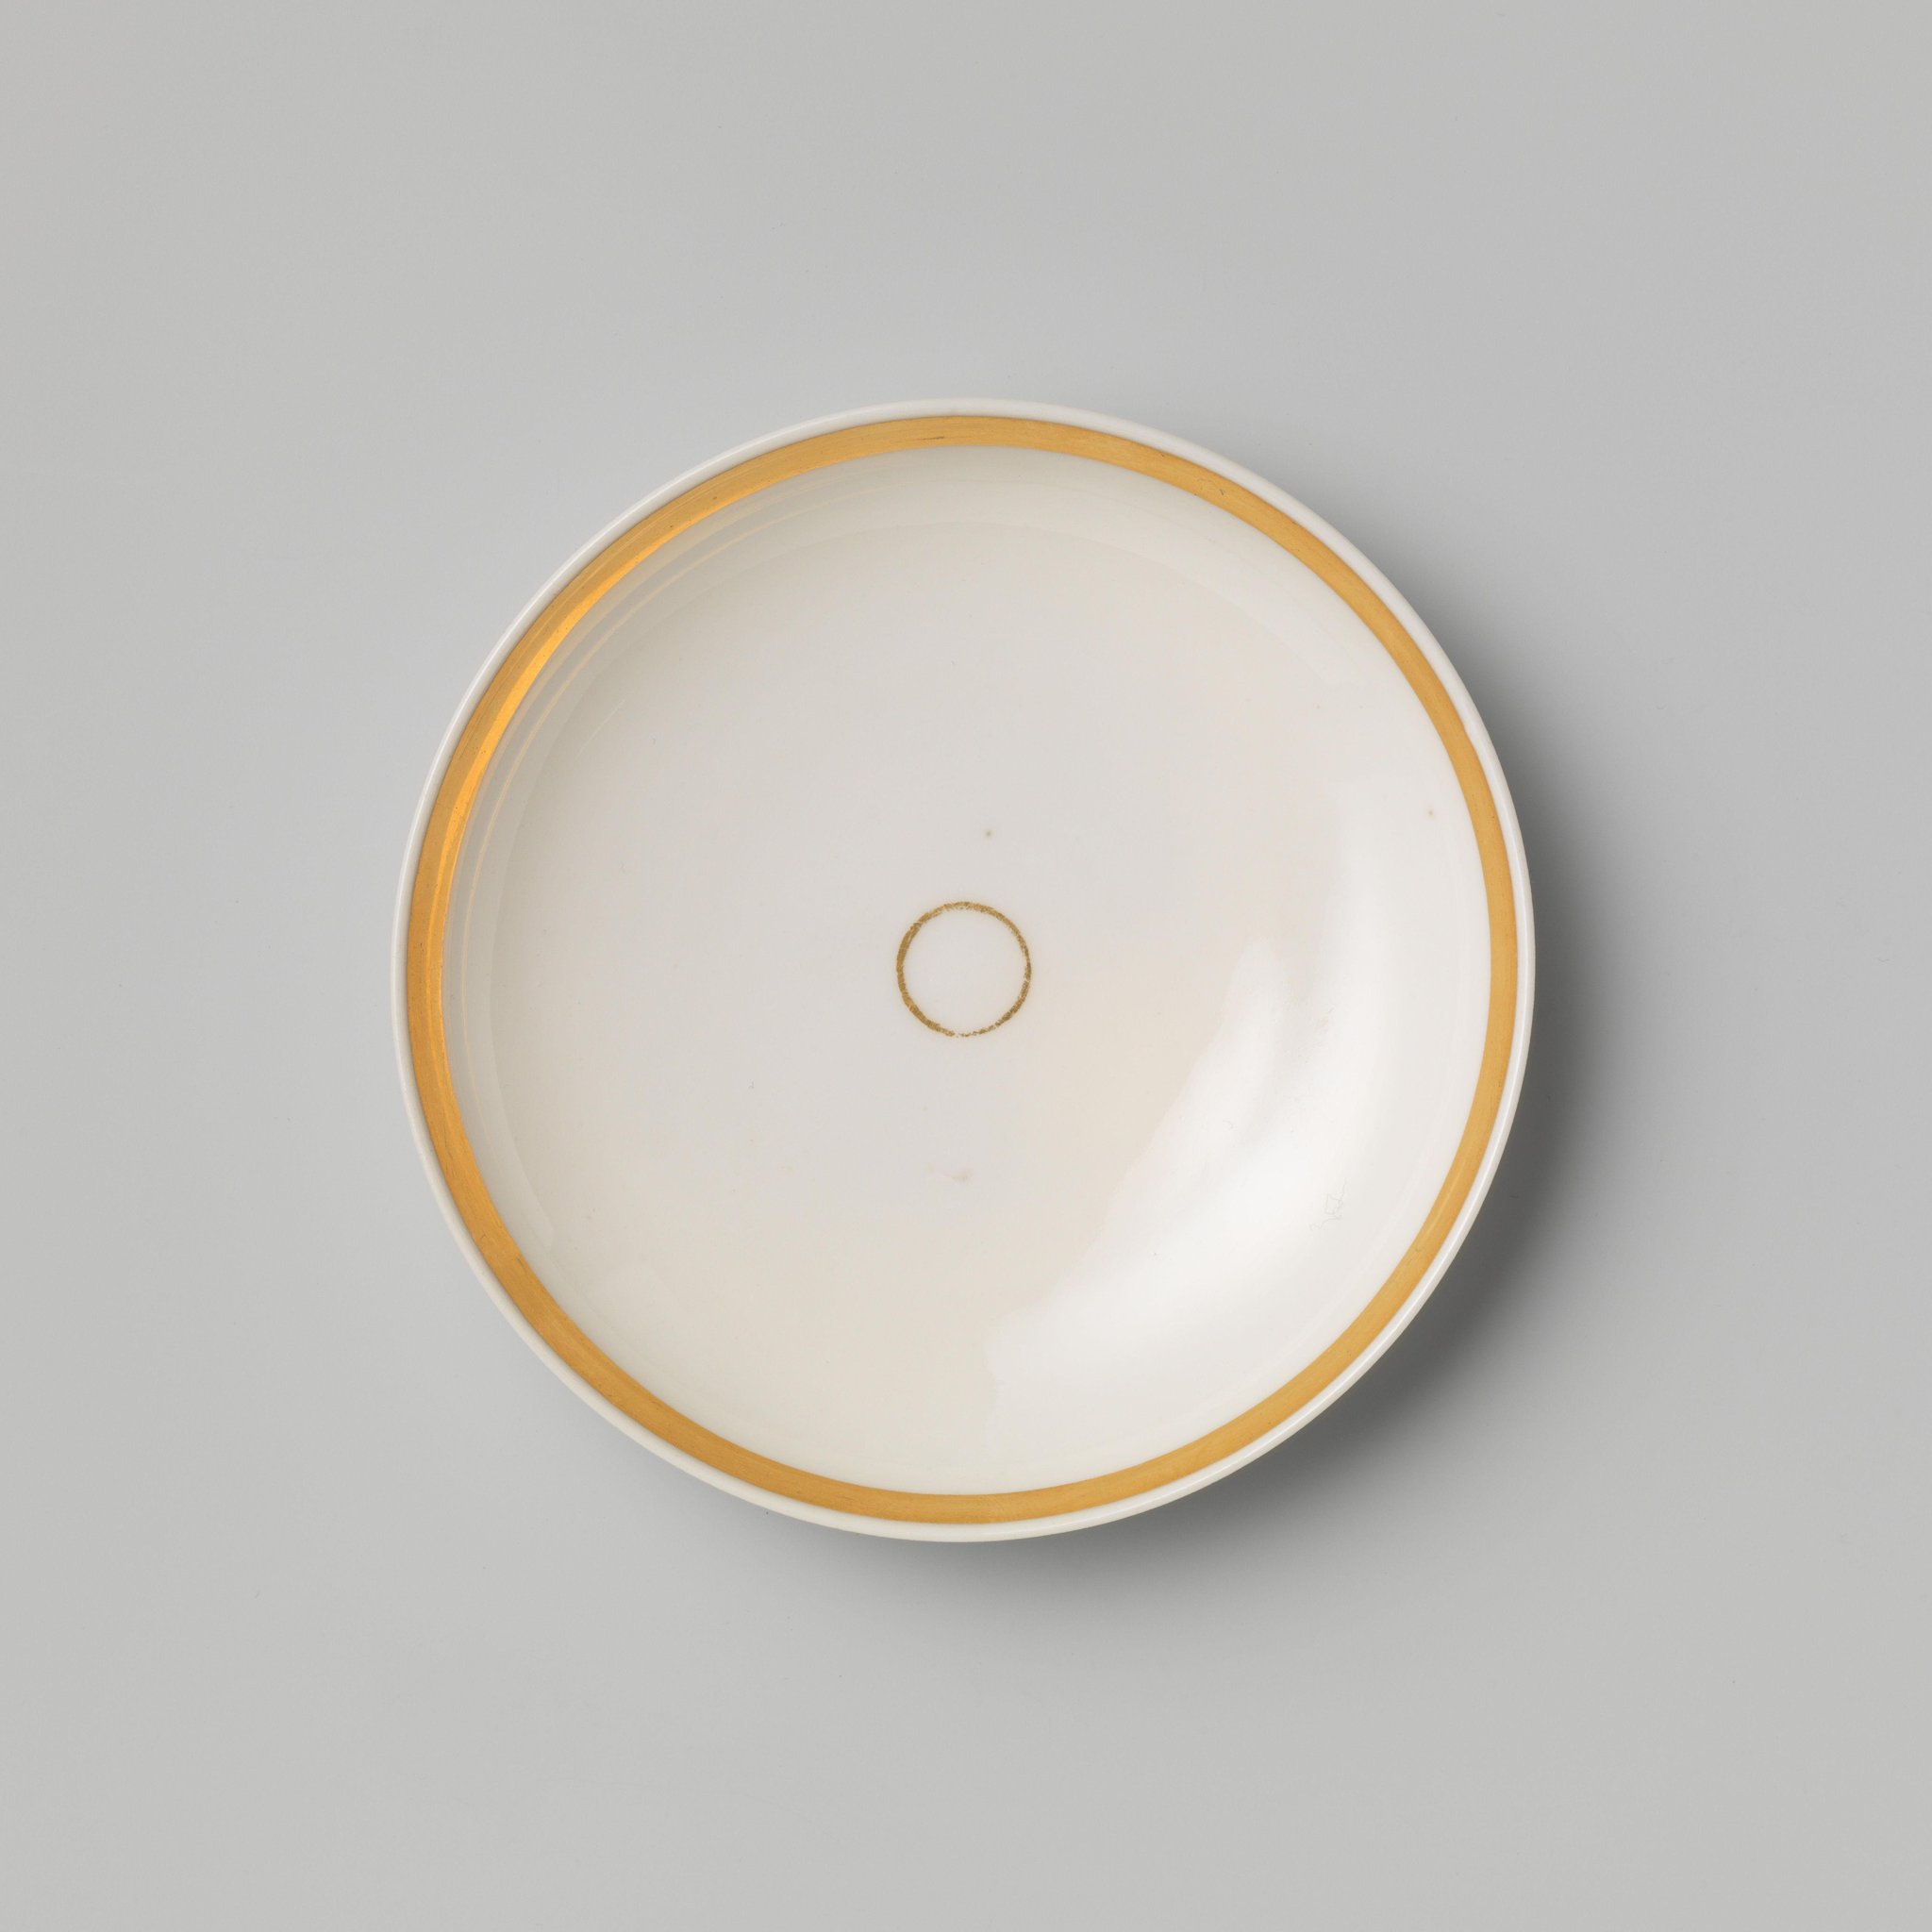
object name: platter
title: Saucer with a medallion and gold border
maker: Anonymous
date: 1850-1899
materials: glaze, gold, paint, porcelain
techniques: firing, forming, gilding, turning, vitrification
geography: europe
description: Schotel van porselein met langs de schotelrand een brede gouden bies en midden op het plat een gouden cirkel. Behoort bij een serie van twaalf kop en schotels waarvan de koppen zijn versierd met een drukdecor in zwart, voorstellende spelende kinderen of volwassenen in een landschap.